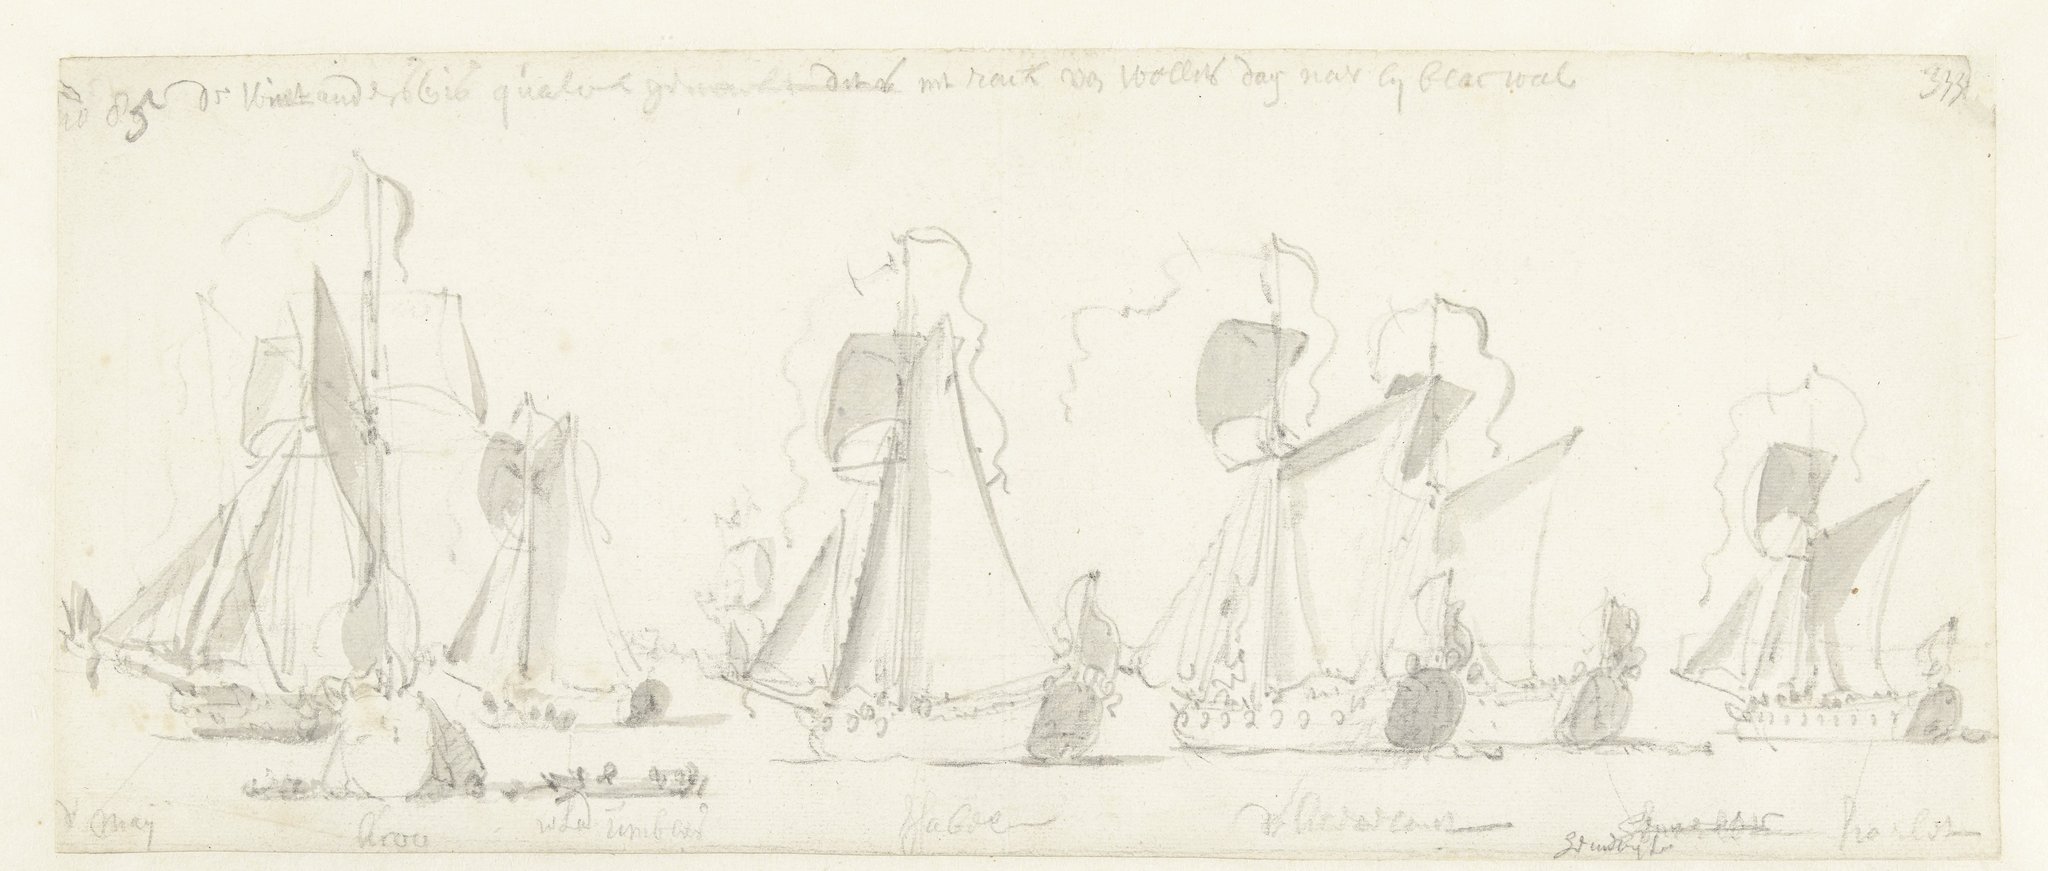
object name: drawing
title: De tocht van de Engelse koning Karel II over de Thames naar Sheerness en Chatham op 27 Augustus 1681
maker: willem van de velde (i)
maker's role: draughtsman, painter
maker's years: 1611-1693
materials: chalk, paper, pencil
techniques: brush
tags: karel ii (koning van engeland), names of artefacts and man-made objects (buildings excluded), river, visiting; receiving guests; elegant company, sailing-ship, sailing-boat (with name), thames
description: De tocht van de Engelse koning Karel II over de Thames naar Sheerness en Chatham op 27 augustus 1681. Hier de vloot van jachten achterelkaar tussen Woolwich en Blackwall, met onder andere de schepen Charlotte, Cleveland, Isabella, Kitchen en Mary.